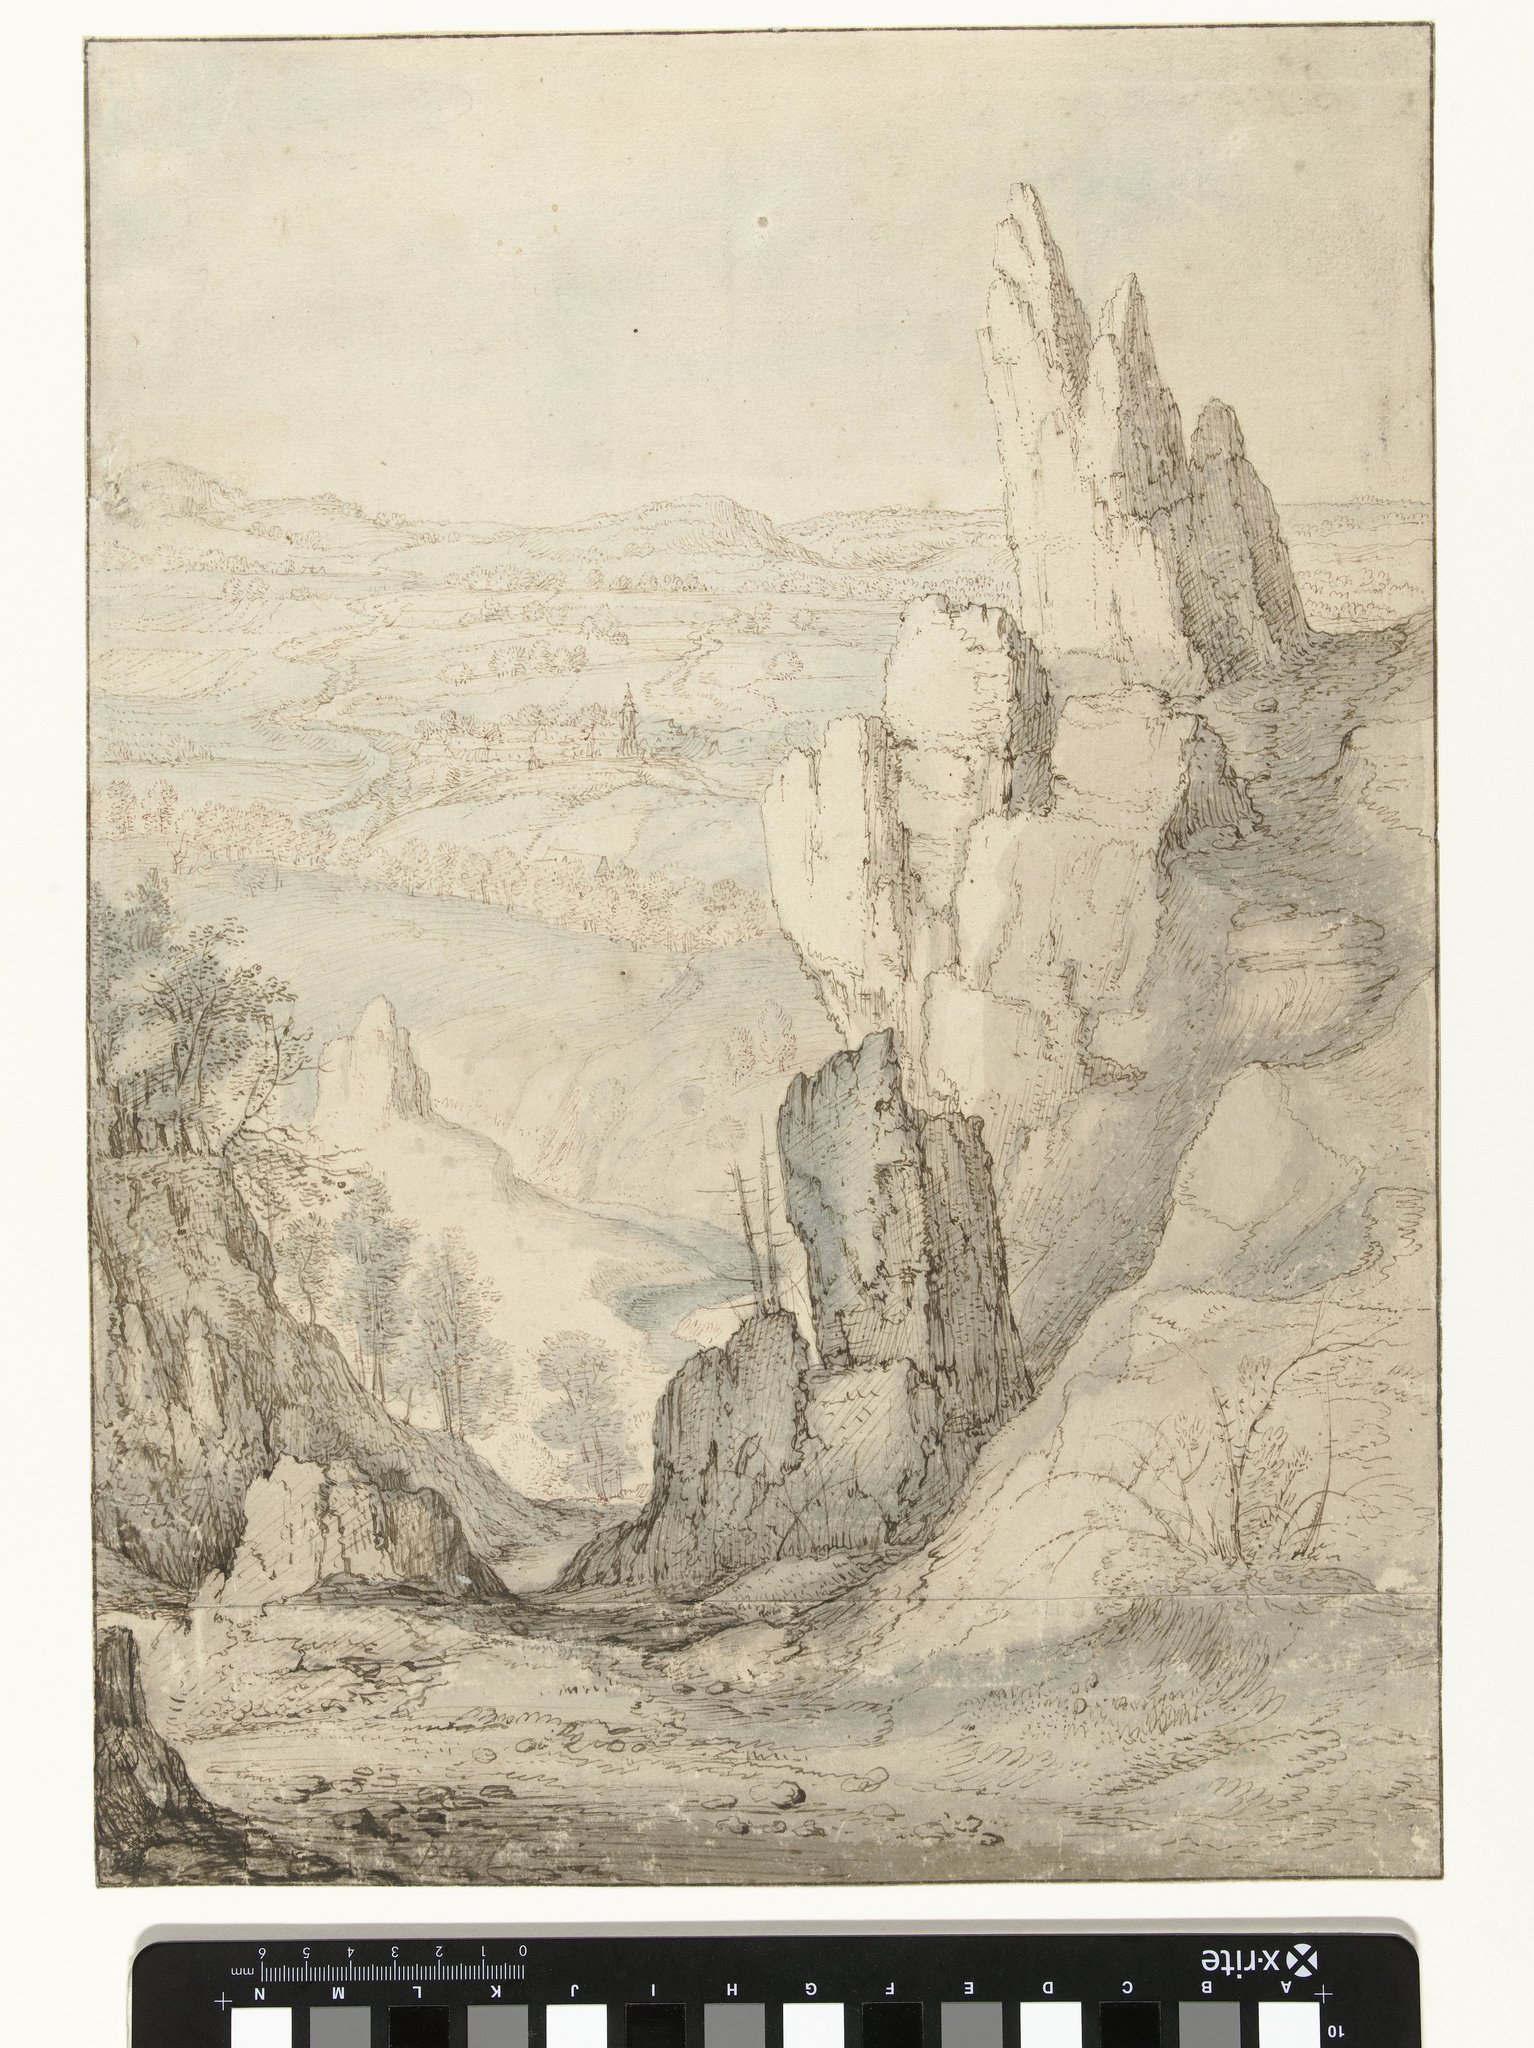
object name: drawing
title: Mountainous Landscape with Steep Cliffs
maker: roelant savery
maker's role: draughtsman, painter, print maker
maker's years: 1576-1639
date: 1603-1613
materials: chalk, graphite, ink, paper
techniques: brush, pen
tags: (high) hill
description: Presumably made during Savery’s trip in the Tyrol, this drawing was once owned by Rembrandt. In the description of his estate, mention is made of a large book containing drawings that Savery made in the Tyrol. After Rembrandt went bankrupt, this album became the property of Lambert Doomer, a gifted amateur draughtsman. Doomer copied several of the drawings in the book, including this one.